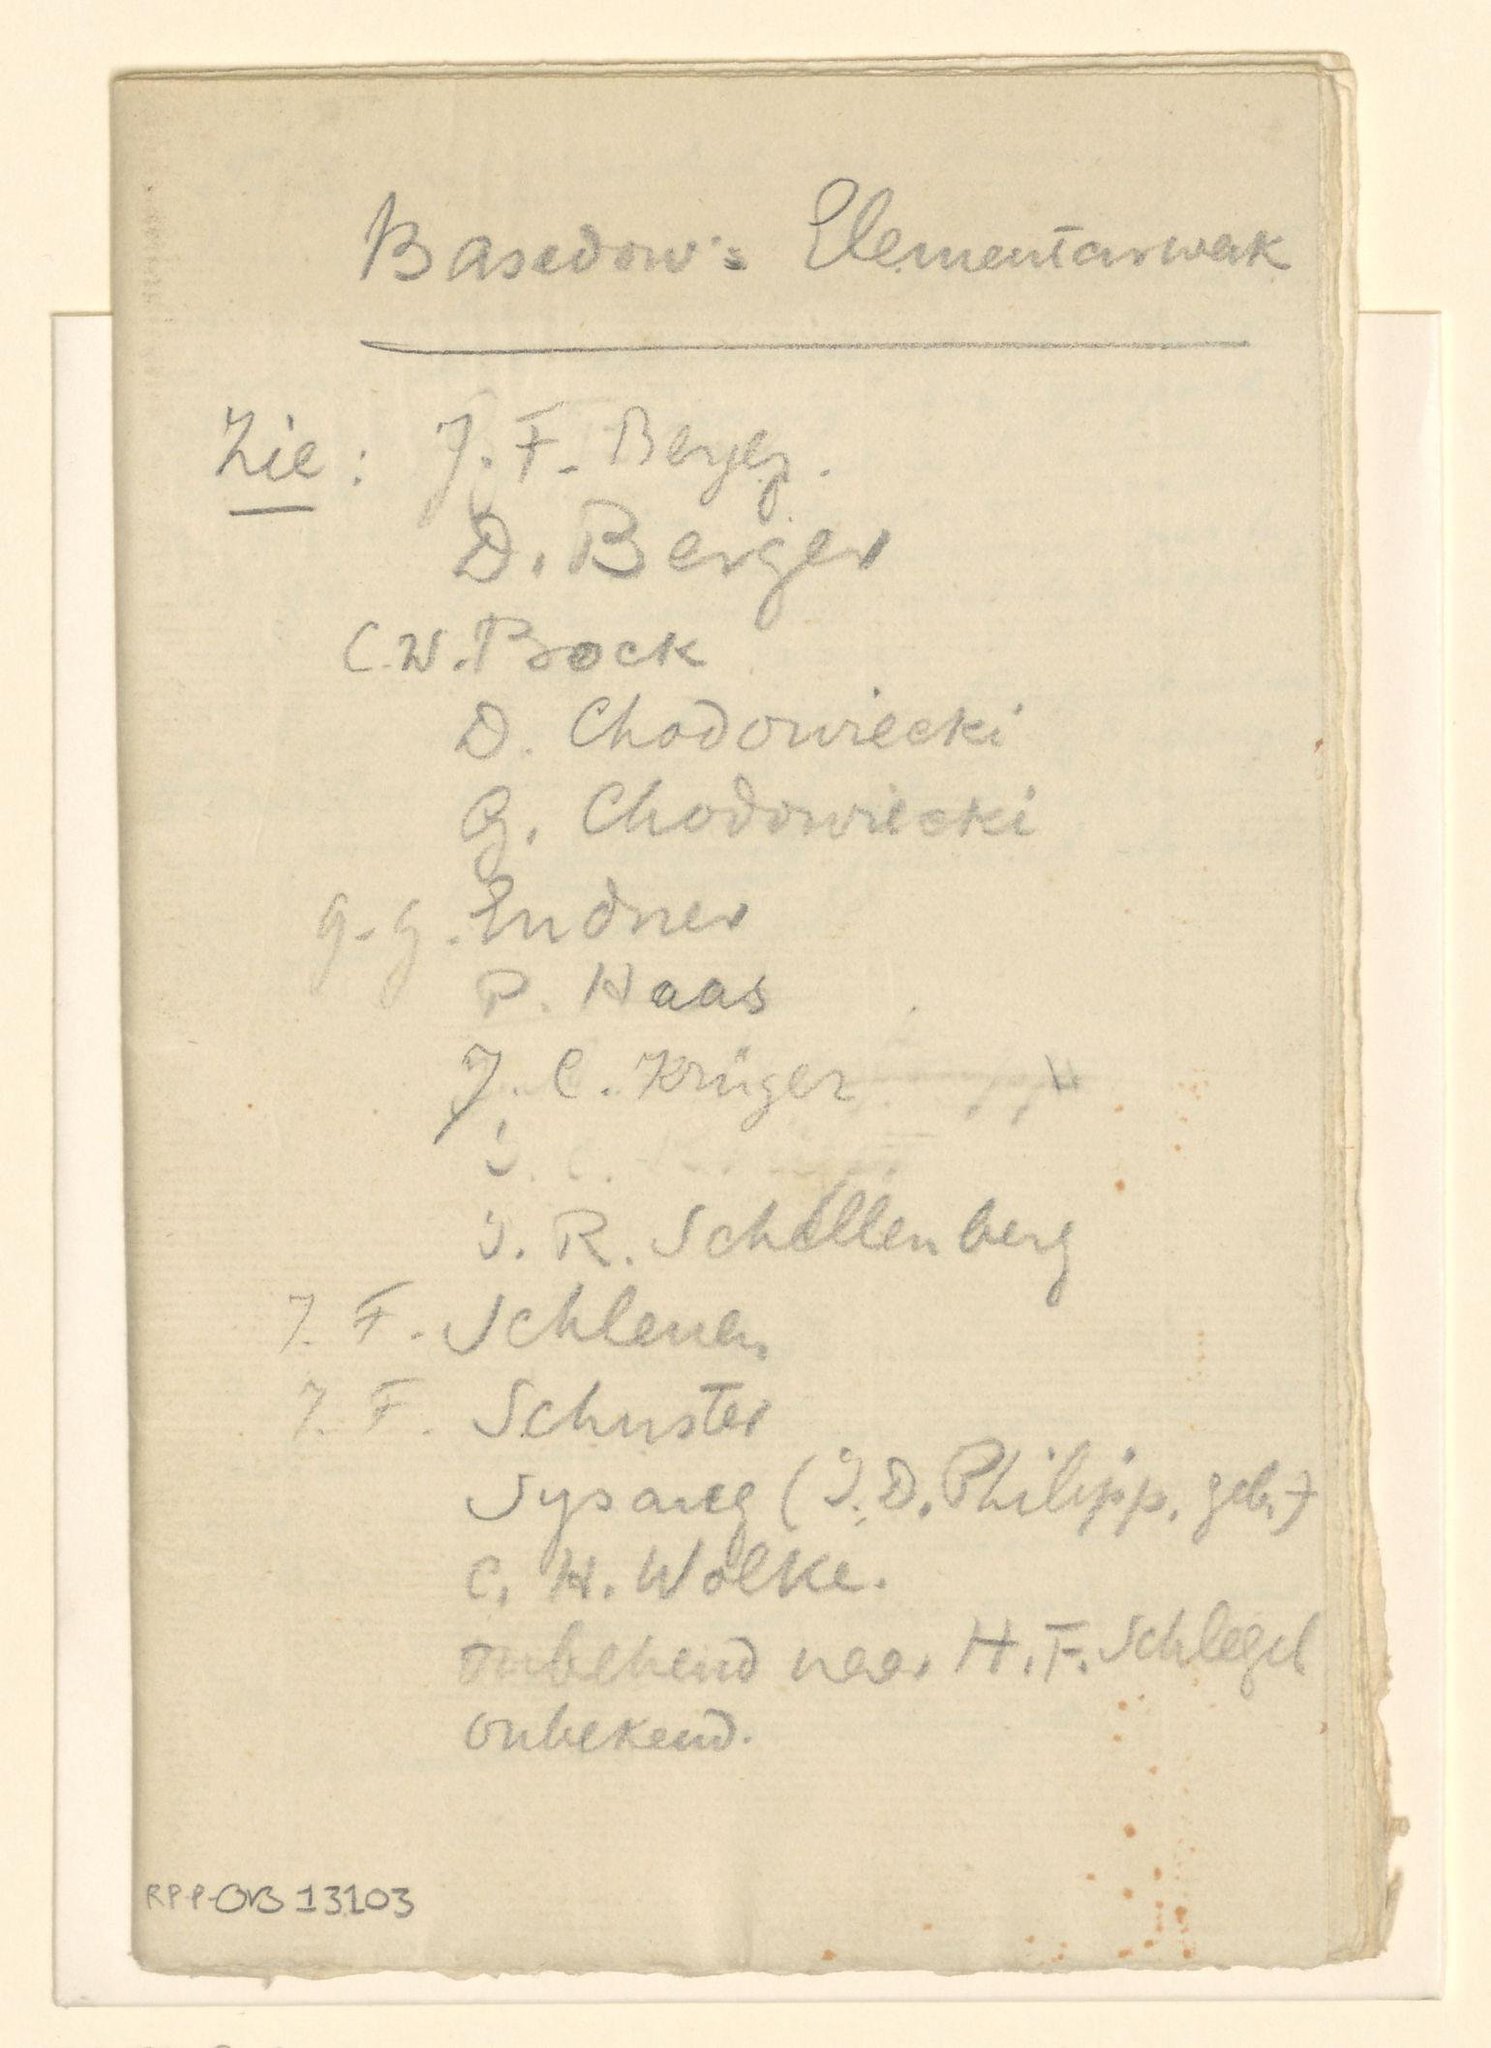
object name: document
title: Table des planches des manuel elémentaire en nouvelle methode d'education par M. Basedow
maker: Anonymous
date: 1772-1825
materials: ink, paper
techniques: pen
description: Handschrift bestaand uit zestien folio's (inclusief omslag) met beschrijvingen in het Frans van de 96 prenten die verschenen ter illustratie van het 'Elementarwerk' van de Duitse pedagoog Johann Bernhard Basedow. De prenten werden door verschillende kunstenaars vervaardigd naar tekeningen van Daniel Chodowiecki. In 1774 verscheen het verzamelde prentwerk bij Crusius in Leipzig onder de titel: Kupfersammlung zu J.B. Basedows Elementarwerk für die Jugend und ihre Freunde.